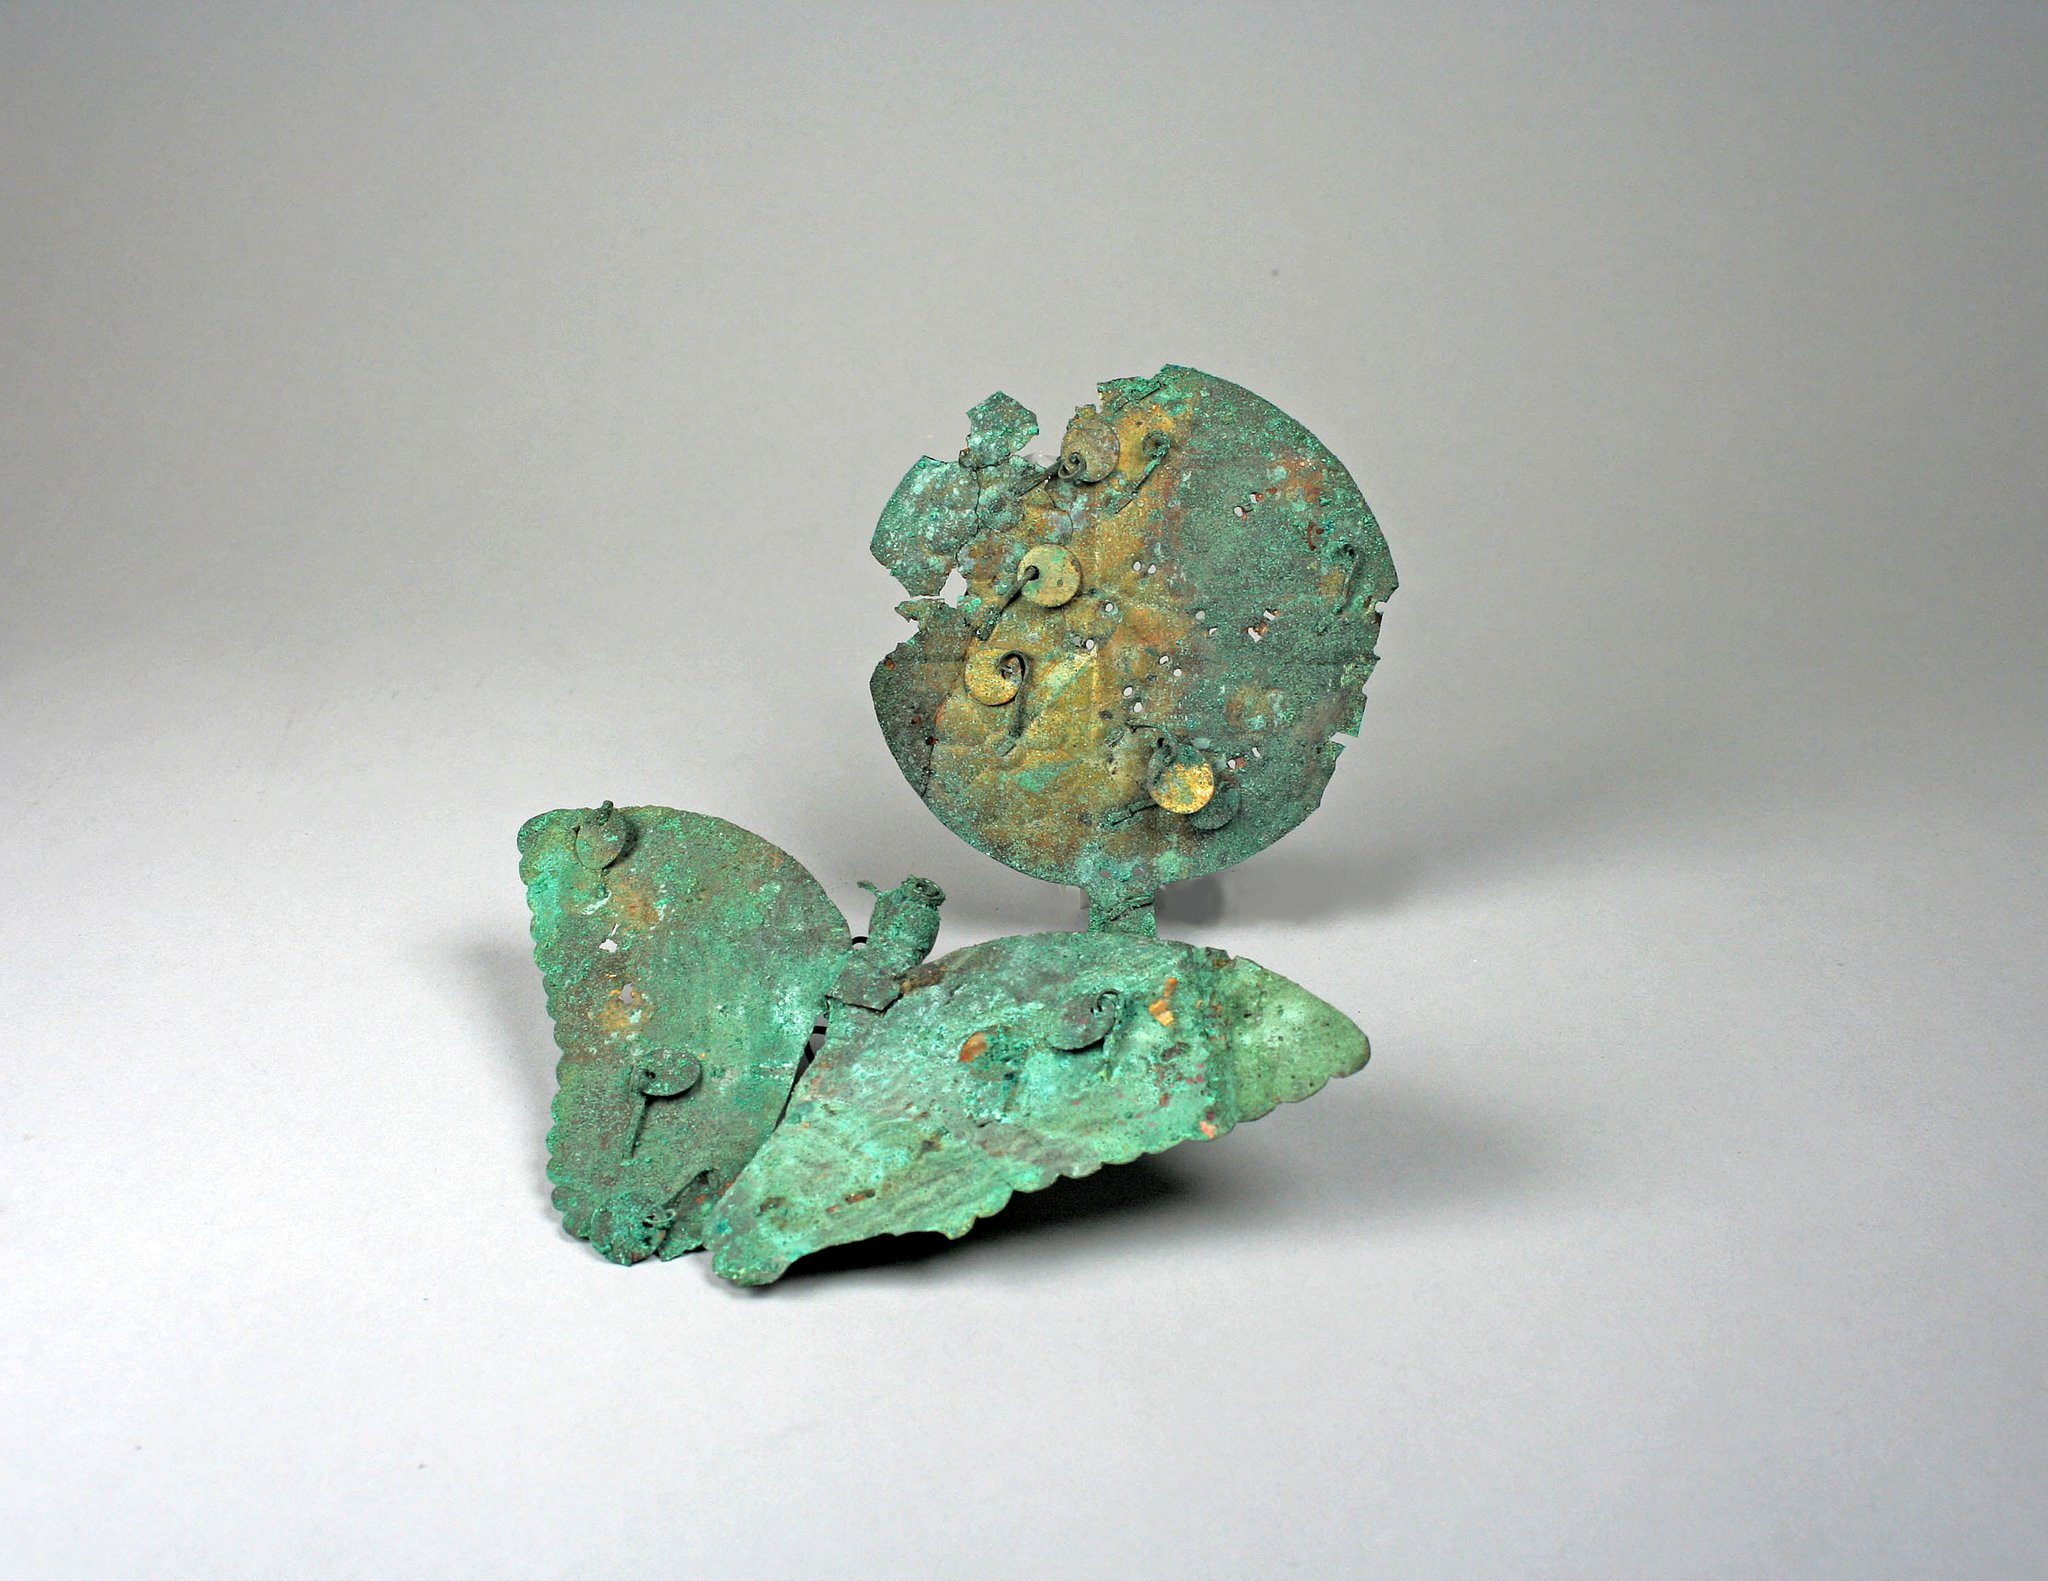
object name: ornament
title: Disk Ornament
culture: moche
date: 501-700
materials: gilt copper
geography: peru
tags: butterflies